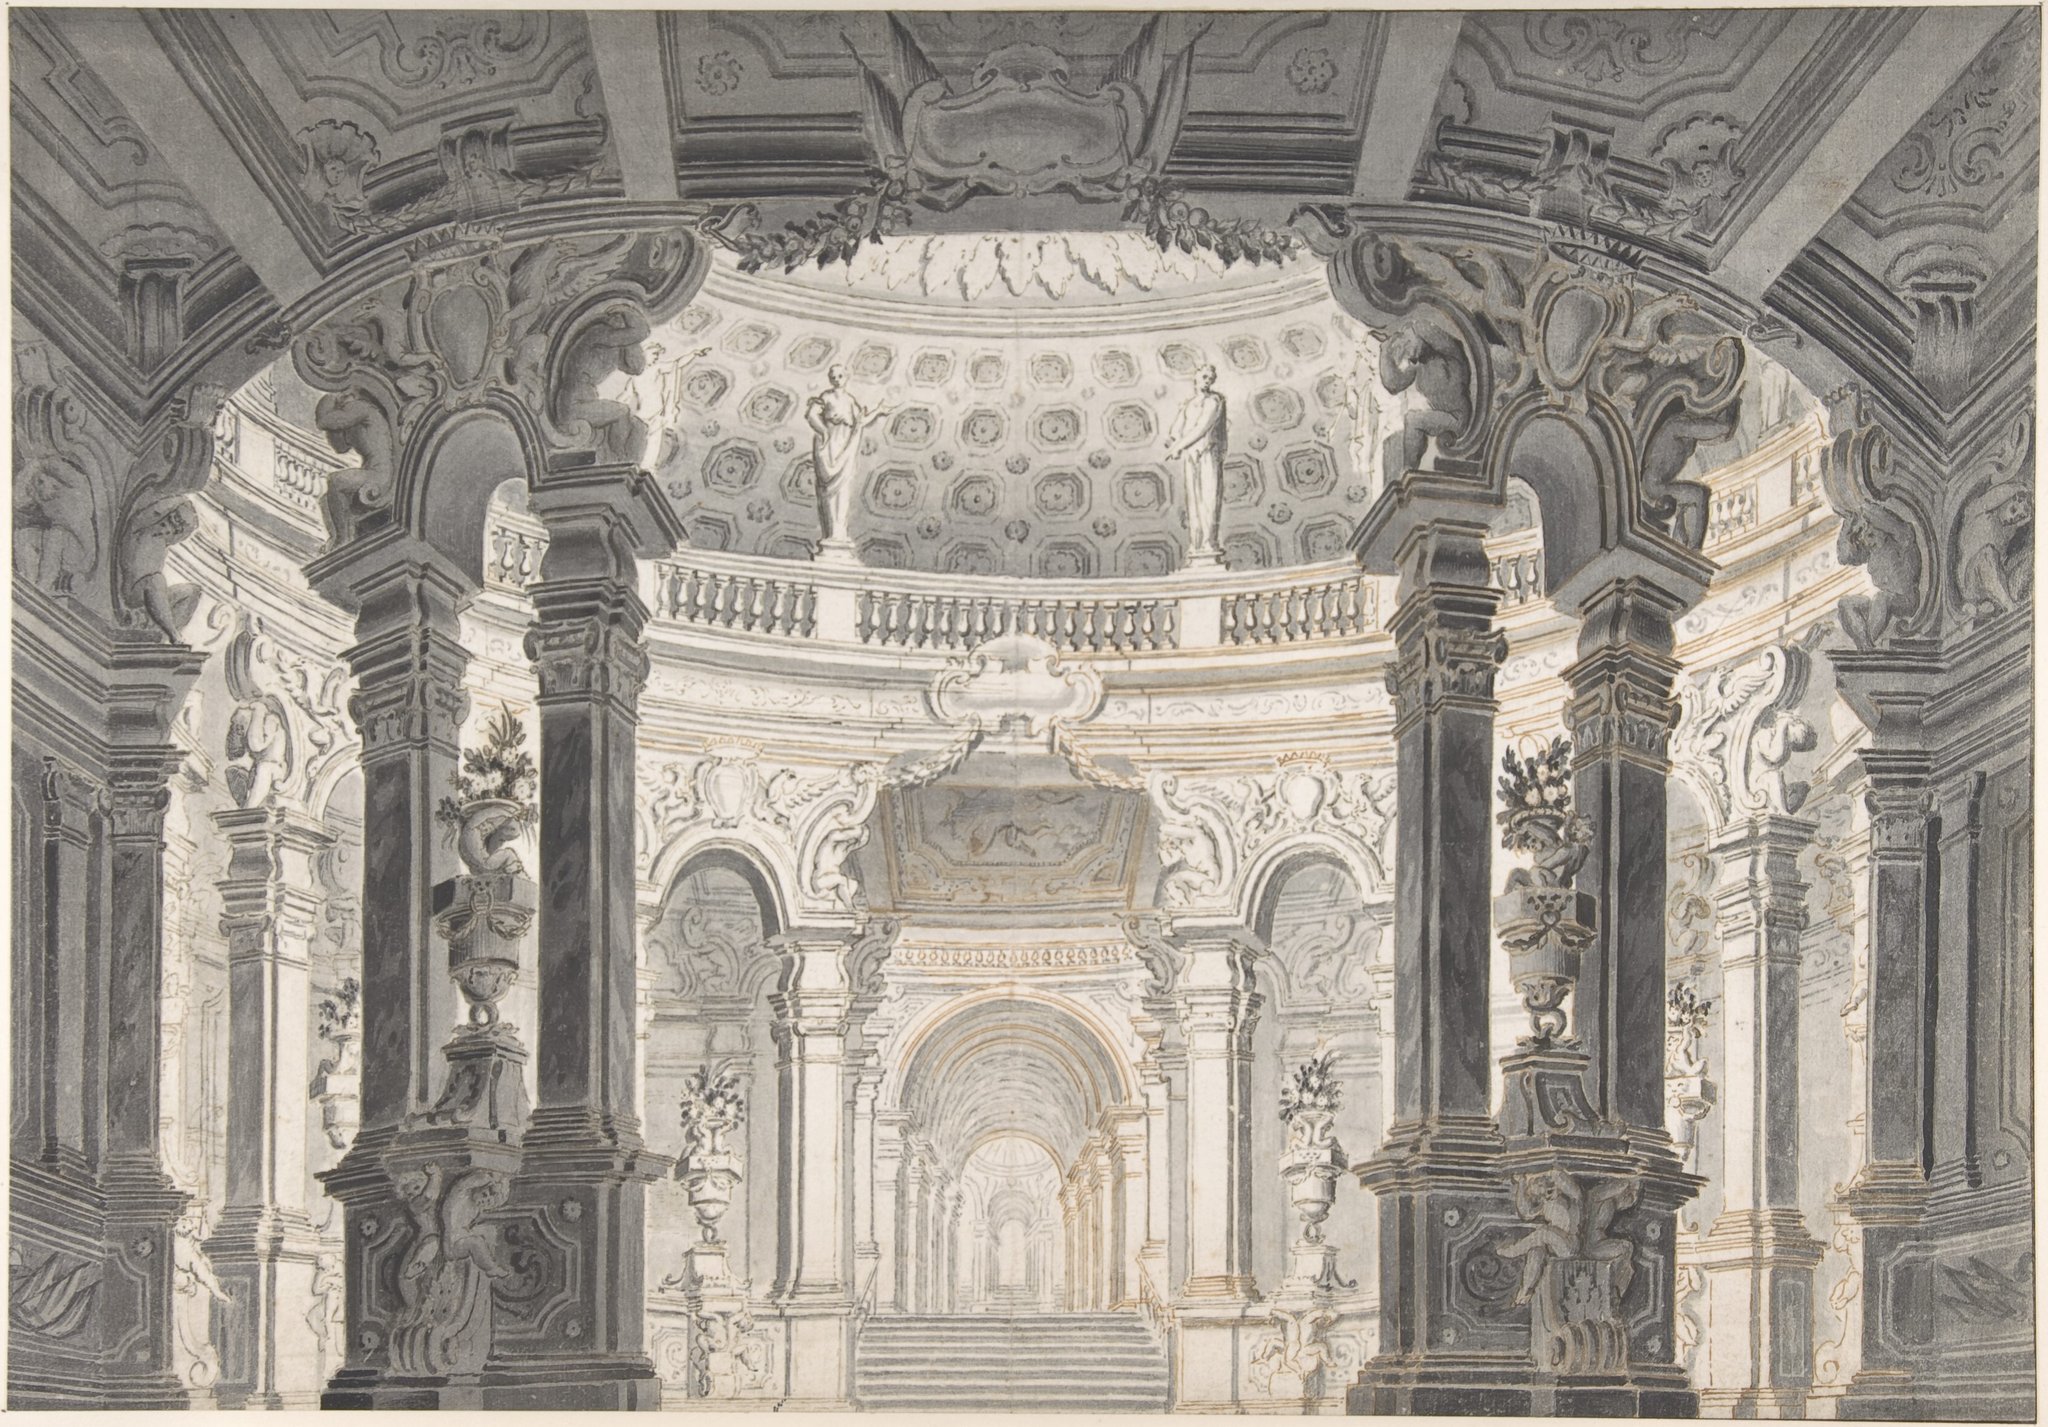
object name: drawing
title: Design for a Stage Set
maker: pietro righini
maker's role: artist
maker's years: 1688-1742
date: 1688-1742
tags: arches,columns,stage design